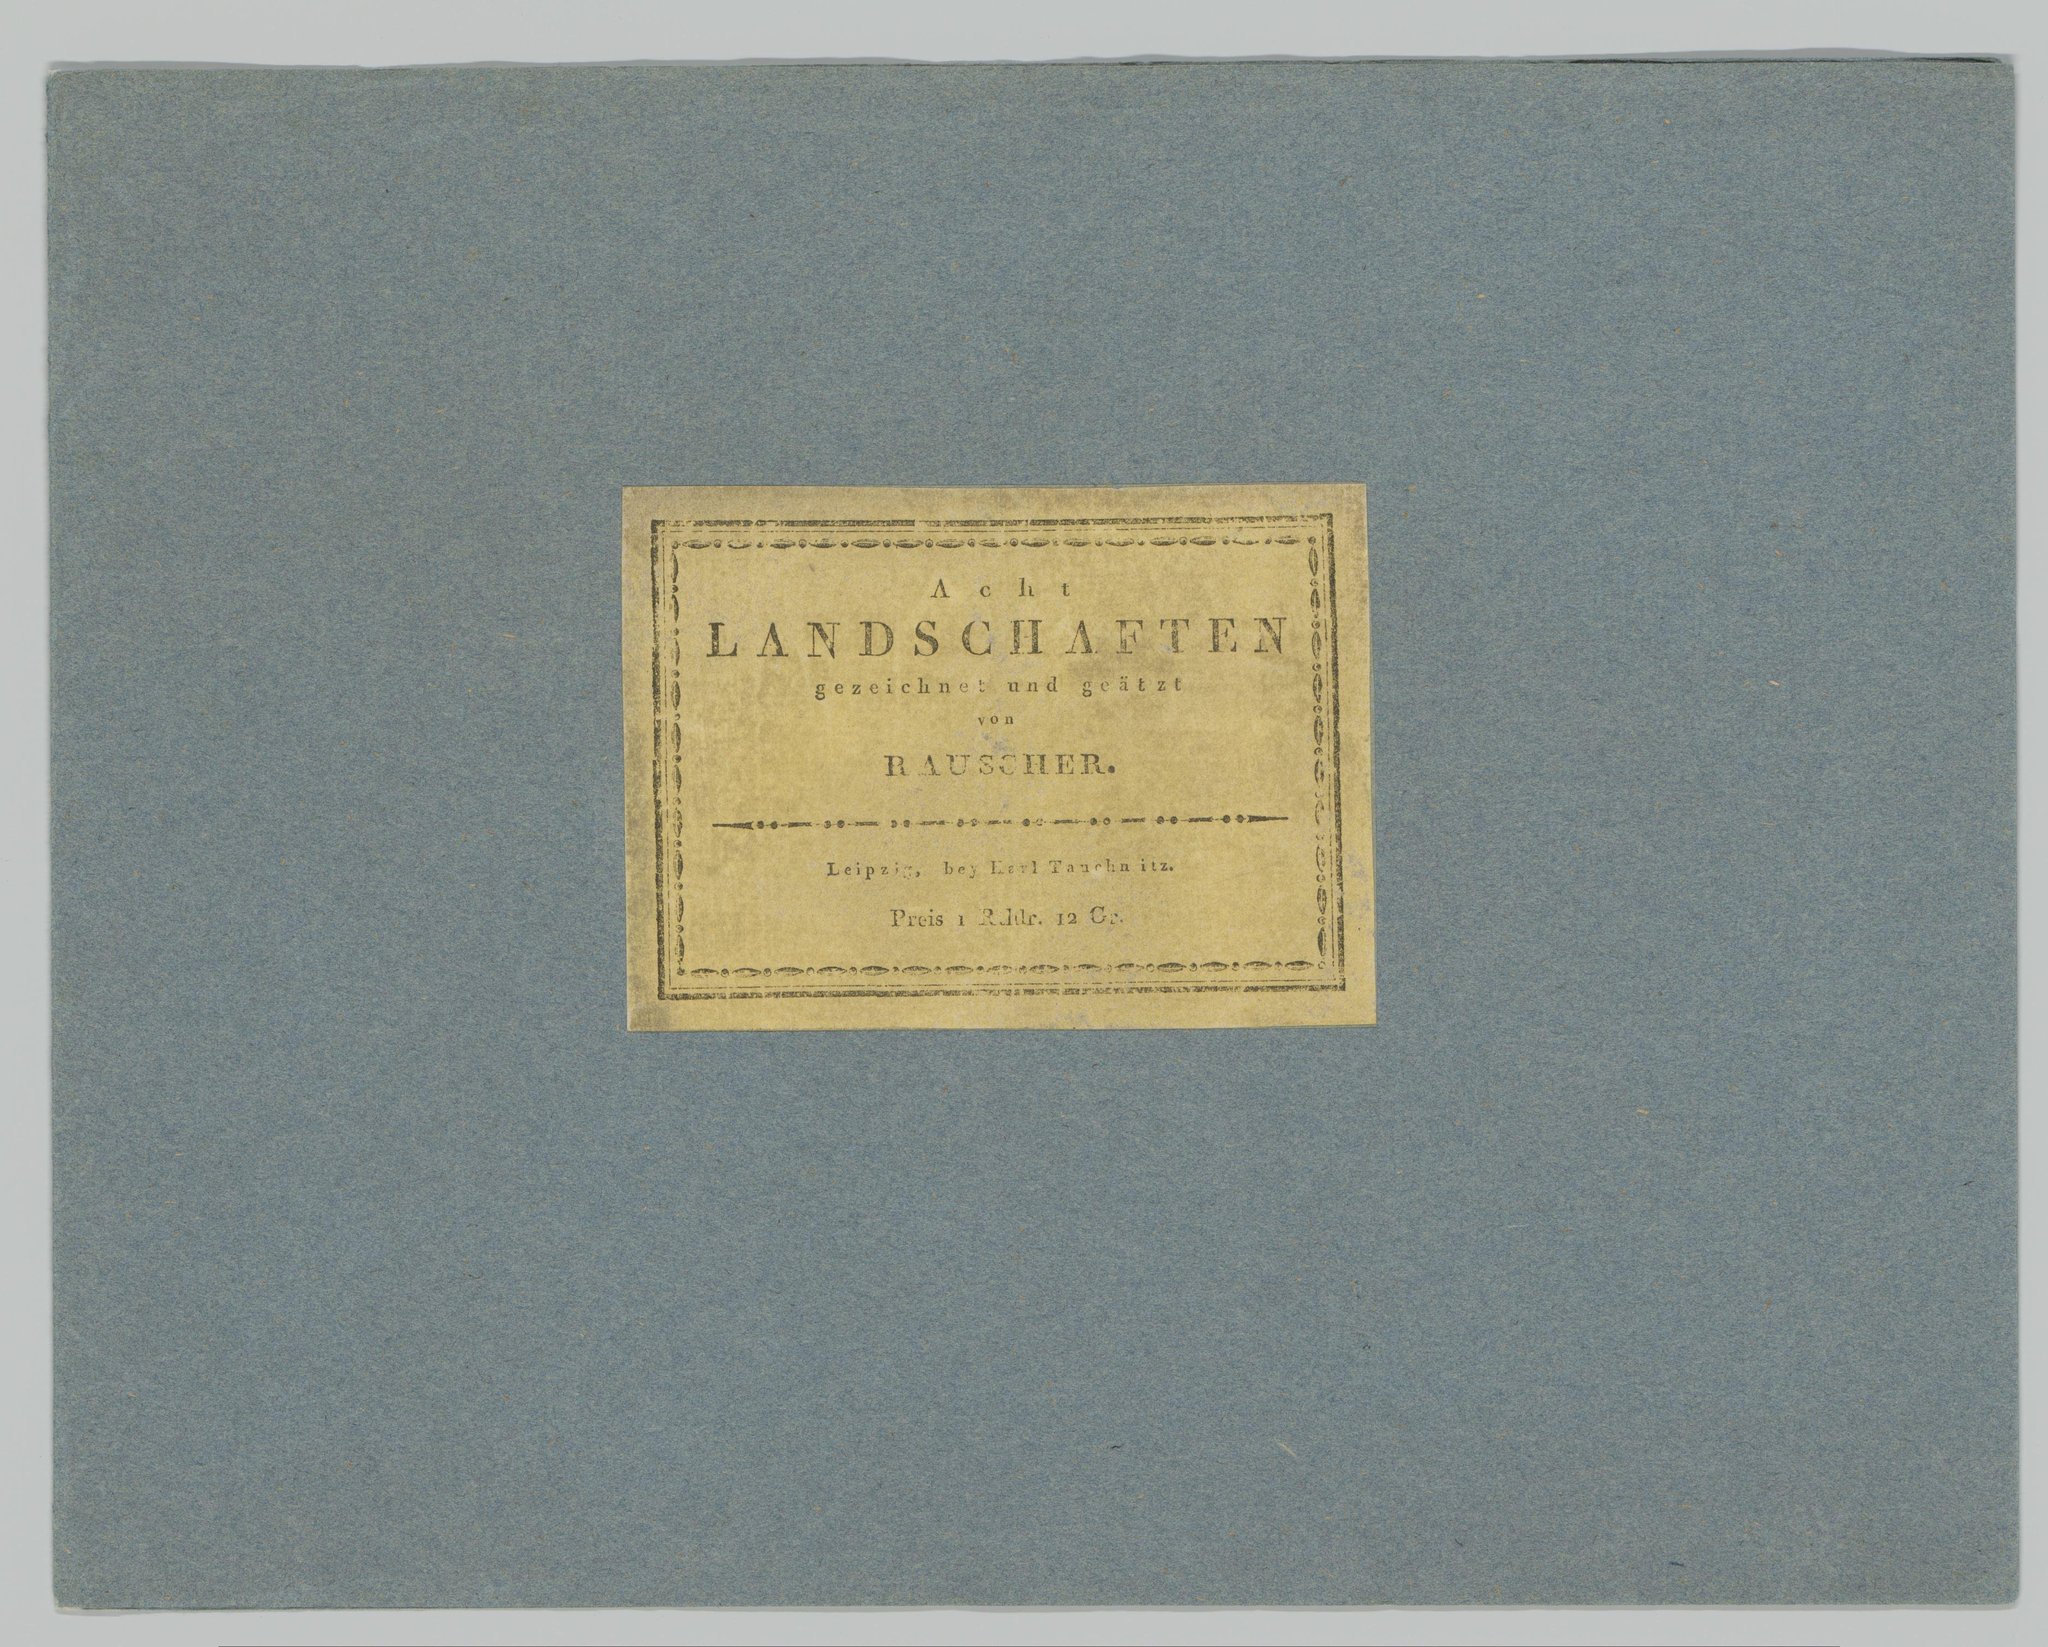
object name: titelprent, frontispice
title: Acht Landschaften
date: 1787-1788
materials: paper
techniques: engraving, letterpress printing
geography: leipzig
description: Titelprent voor een serie van acht bosrijke landschappen.